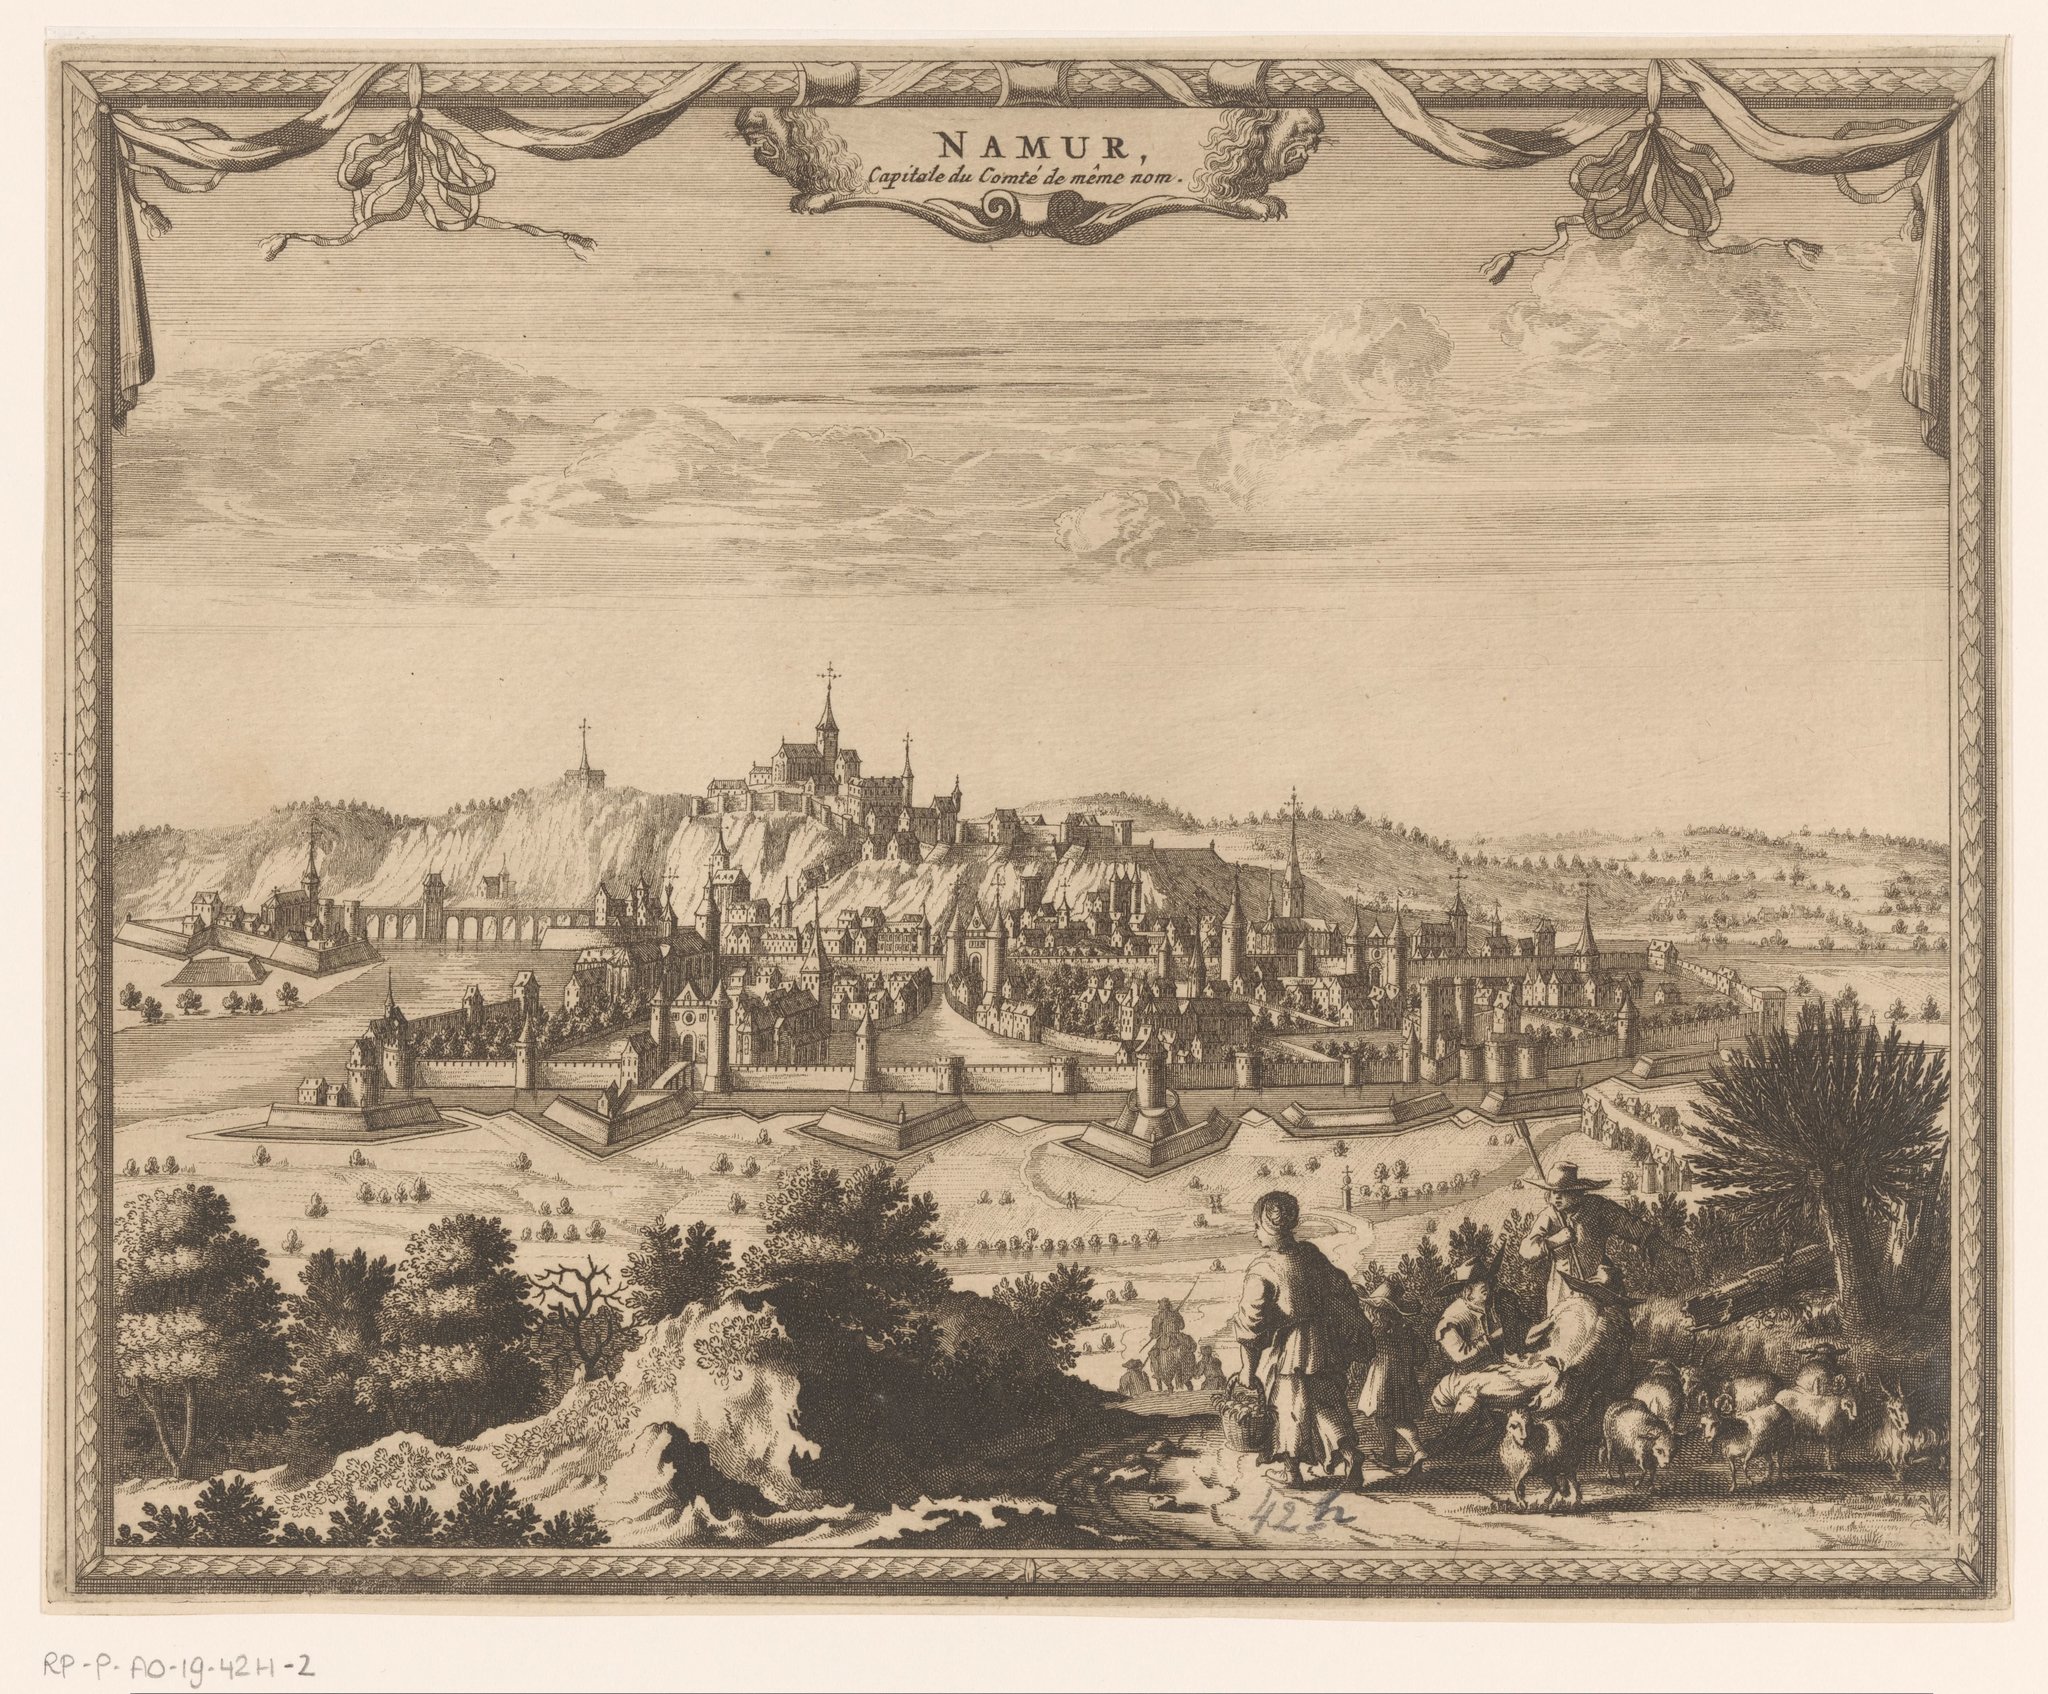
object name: print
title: Namur, capitale du comté de même nom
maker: Anonymous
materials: paper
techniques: etching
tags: fortified city, herd, flock, prospect of city, town panorama, silhouette of city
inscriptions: collector's mark: Lugt 2228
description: Huidige staat van prent ook gebruikt in: Aa, Pieter van der. Europa. Leiden: Pieter van der Aa, s.a. [ca. 1715]. En in: Afbeeldinghe der voornaemste steeden van Nederlant / Les principales villes des Pais-bas. Amsteram: Covens & Mortier, s.a. [na 1721]. Huidige staat met apart gedrukte sierrand gebruikt in: Aa, Pieter van der. La galerie agreable du monde (...). 66 delen. Leiden: Pieter van der Aa, 1728, dl. 16.